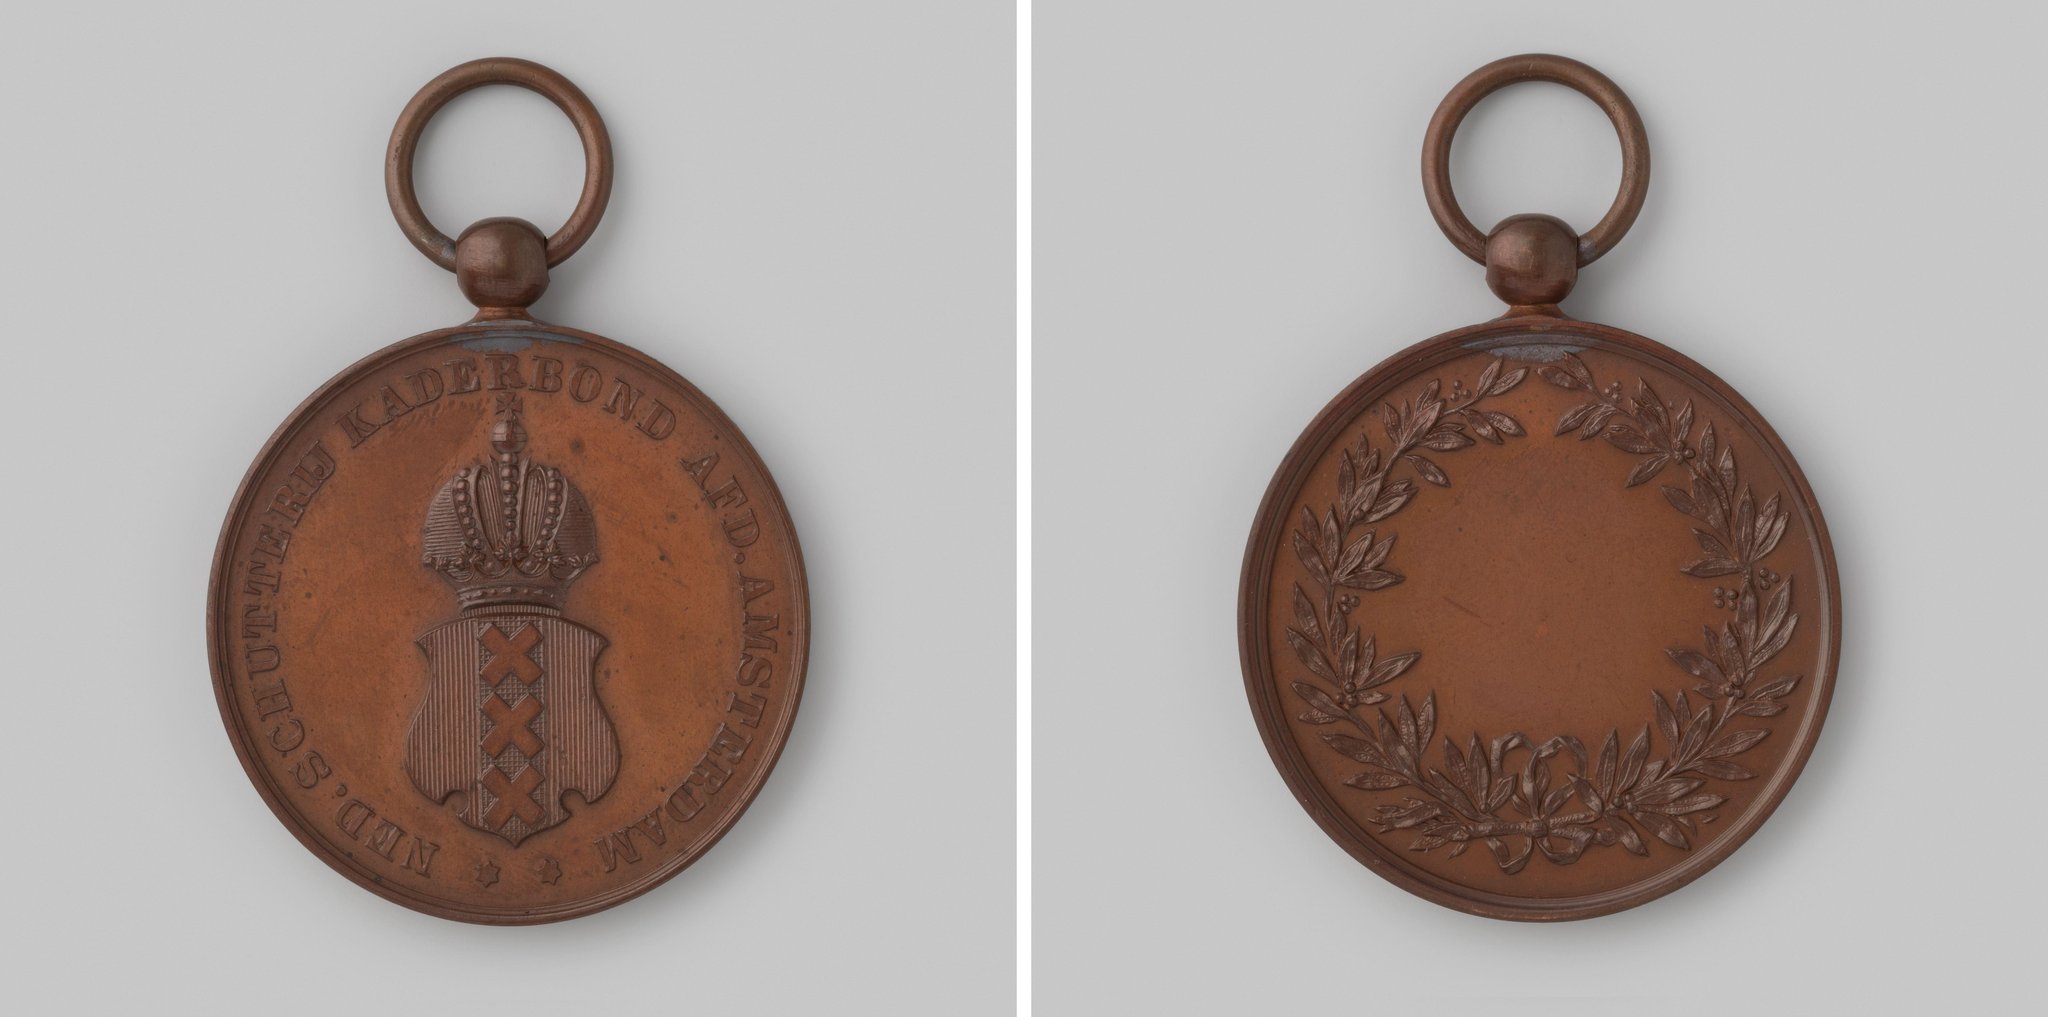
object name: medal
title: Afslag van de prijspenning van de afdeling Amsterdam van de Nederlandschen Schutterij Kaderbond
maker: Anonymous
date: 1891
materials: bronze